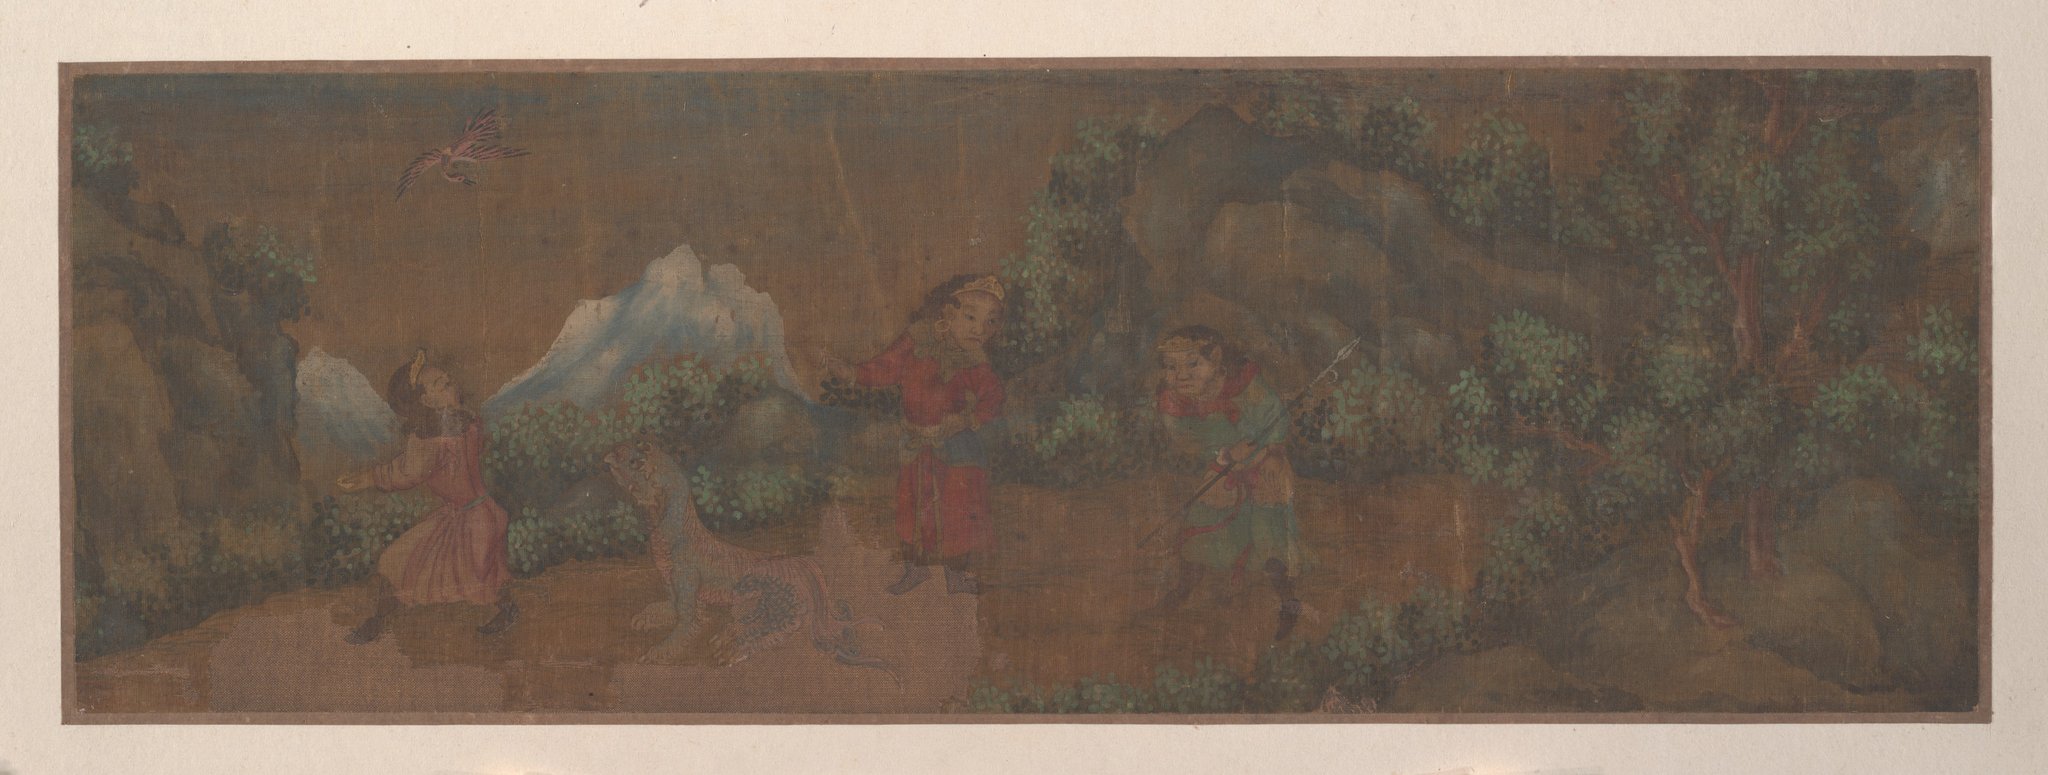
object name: album leaf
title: Landscape Painting of Figure in Woodland Setting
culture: chinese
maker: unidentified artist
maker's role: artist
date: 1644-1911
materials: silk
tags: birds,women,mythical creatures,landscapes